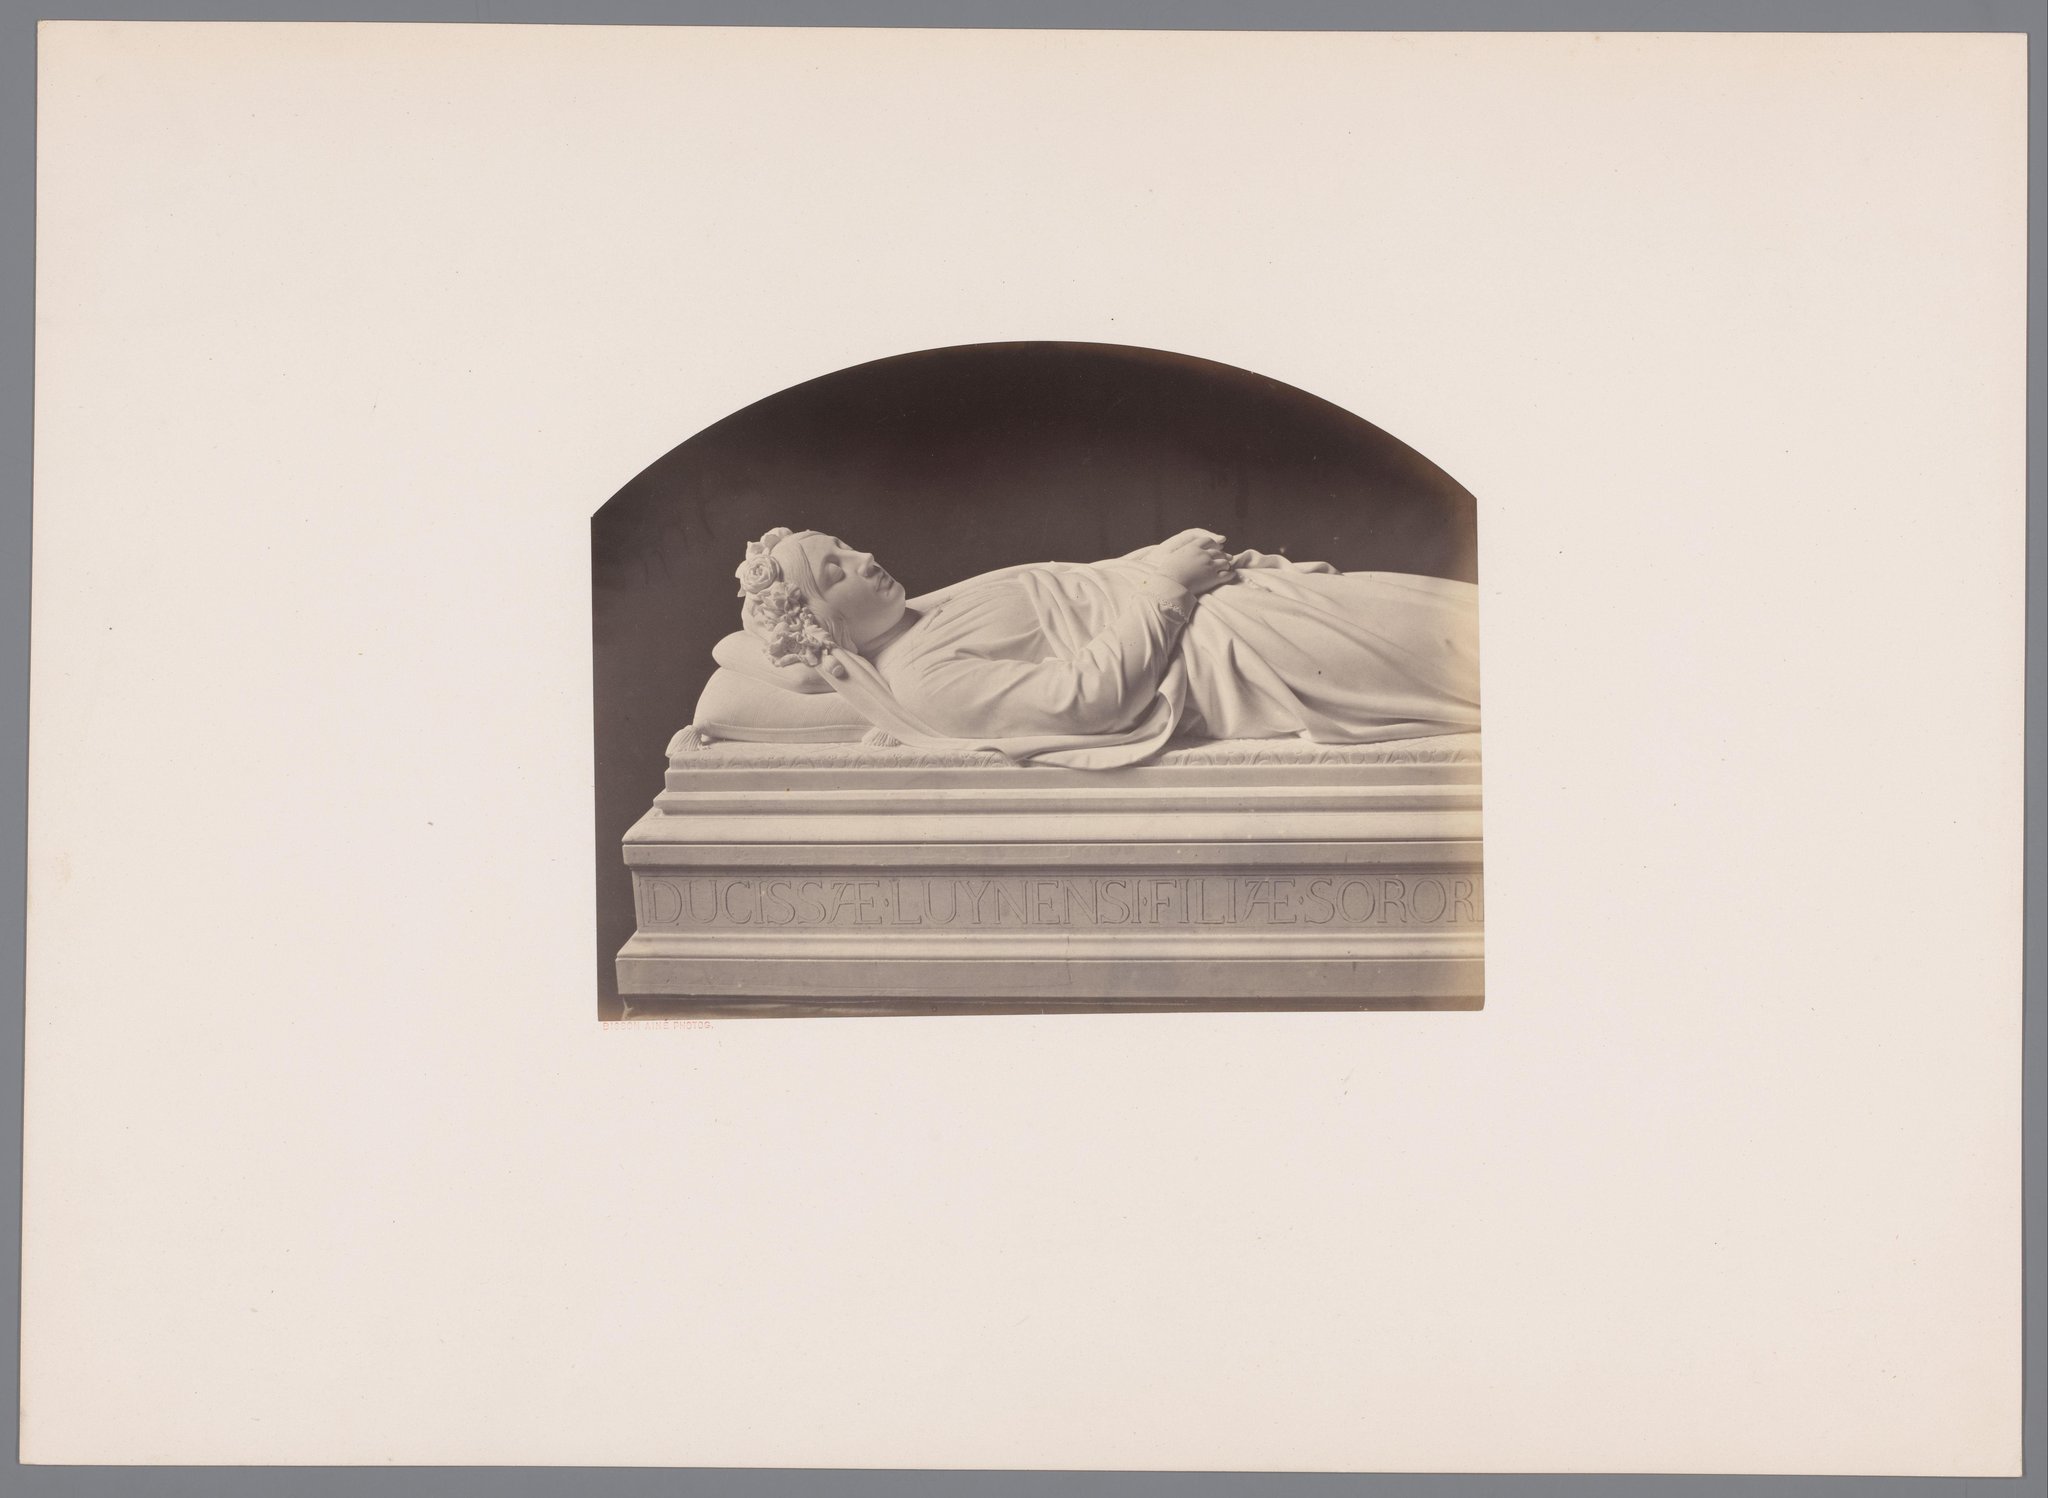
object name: photograph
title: Graftombe van Duchesse de Luynes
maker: louis-auguste bisson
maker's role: fotograaf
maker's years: 1814-1876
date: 1860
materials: cardboard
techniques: albumen print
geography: france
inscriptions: check stamp: ‘Provenance Estate Duc de Luynes’